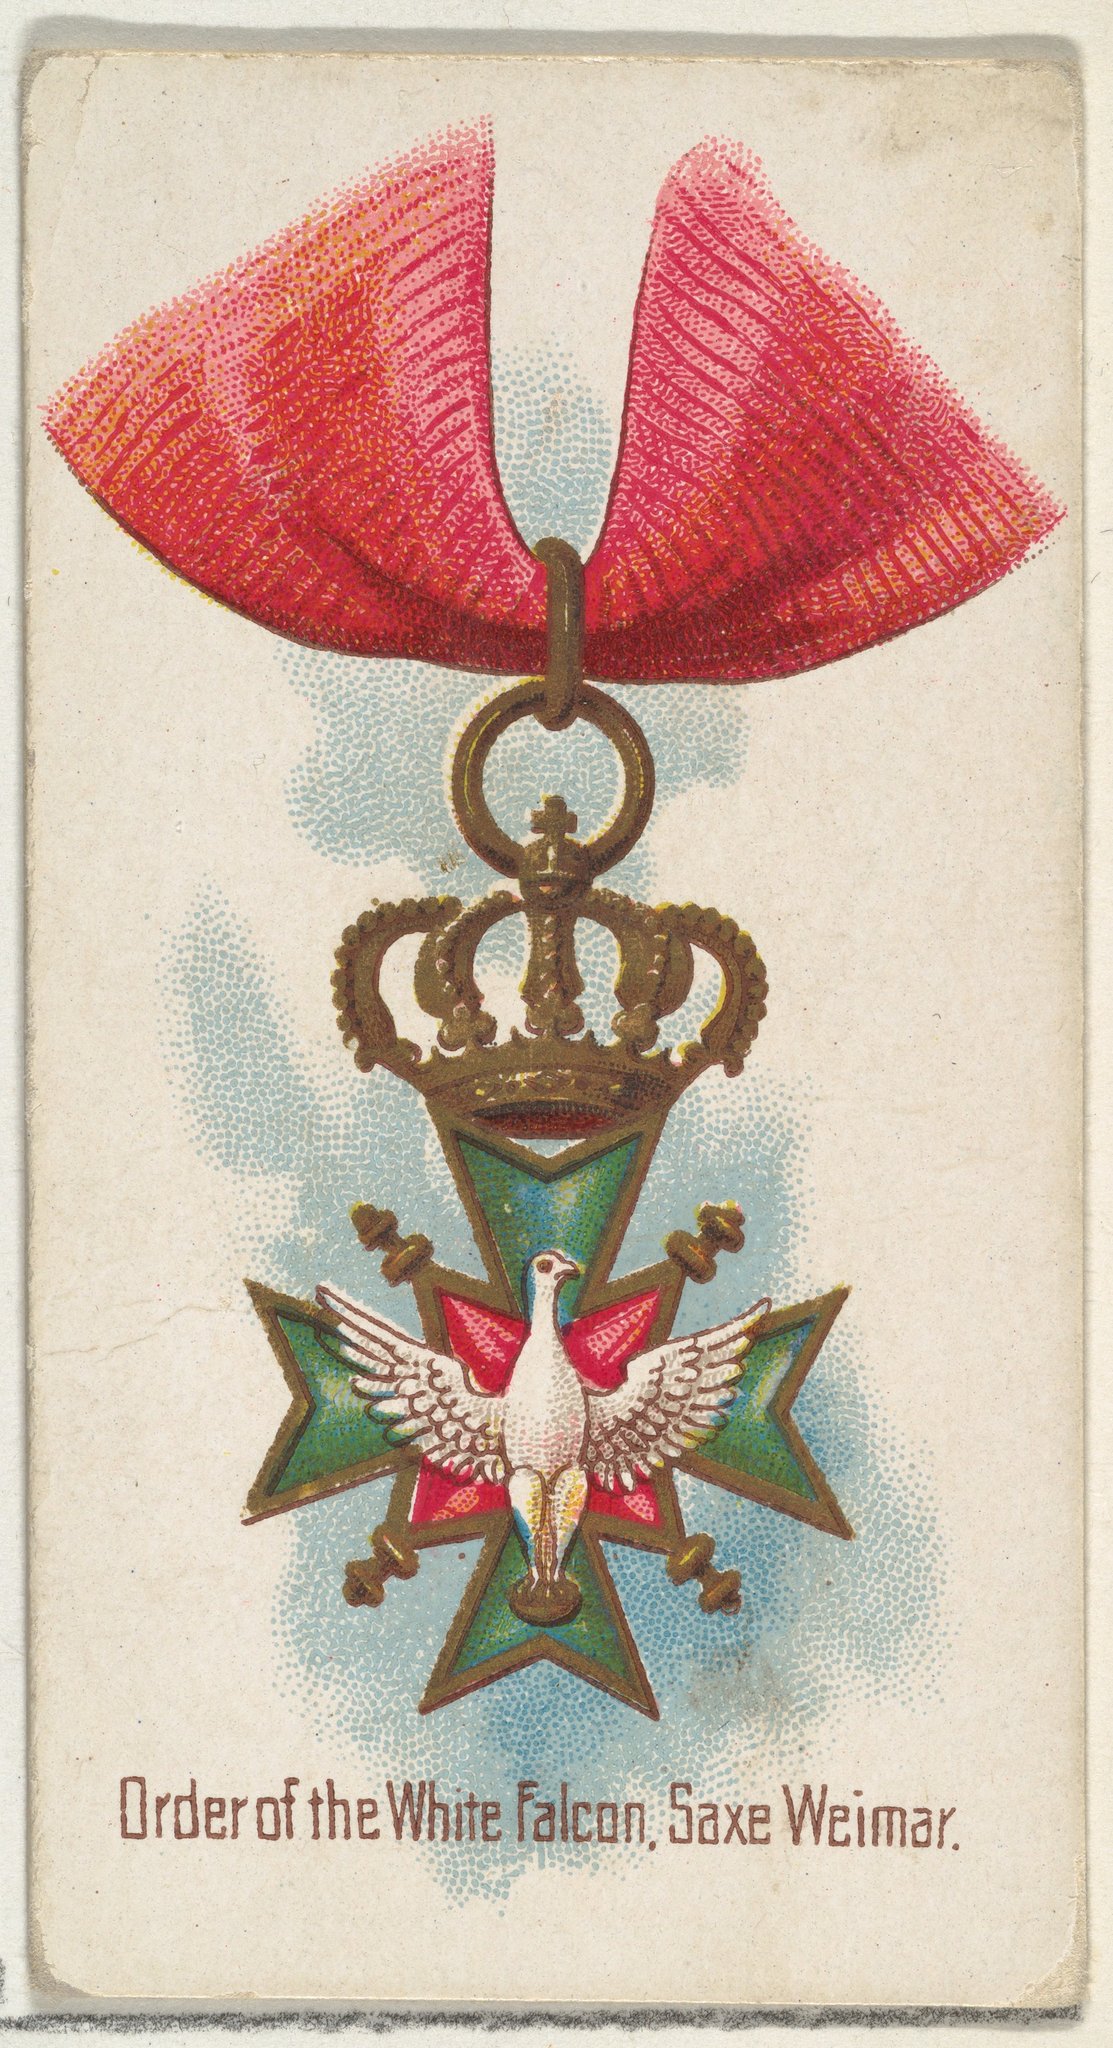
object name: print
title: Order of the White Falcon, Saxe Weimar, from the World's Decorations series (N30) for Allen & Ginter Cigarettes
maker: allen & ginter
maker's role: publisher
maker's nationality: american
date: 1890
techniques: color lithograph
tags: medals